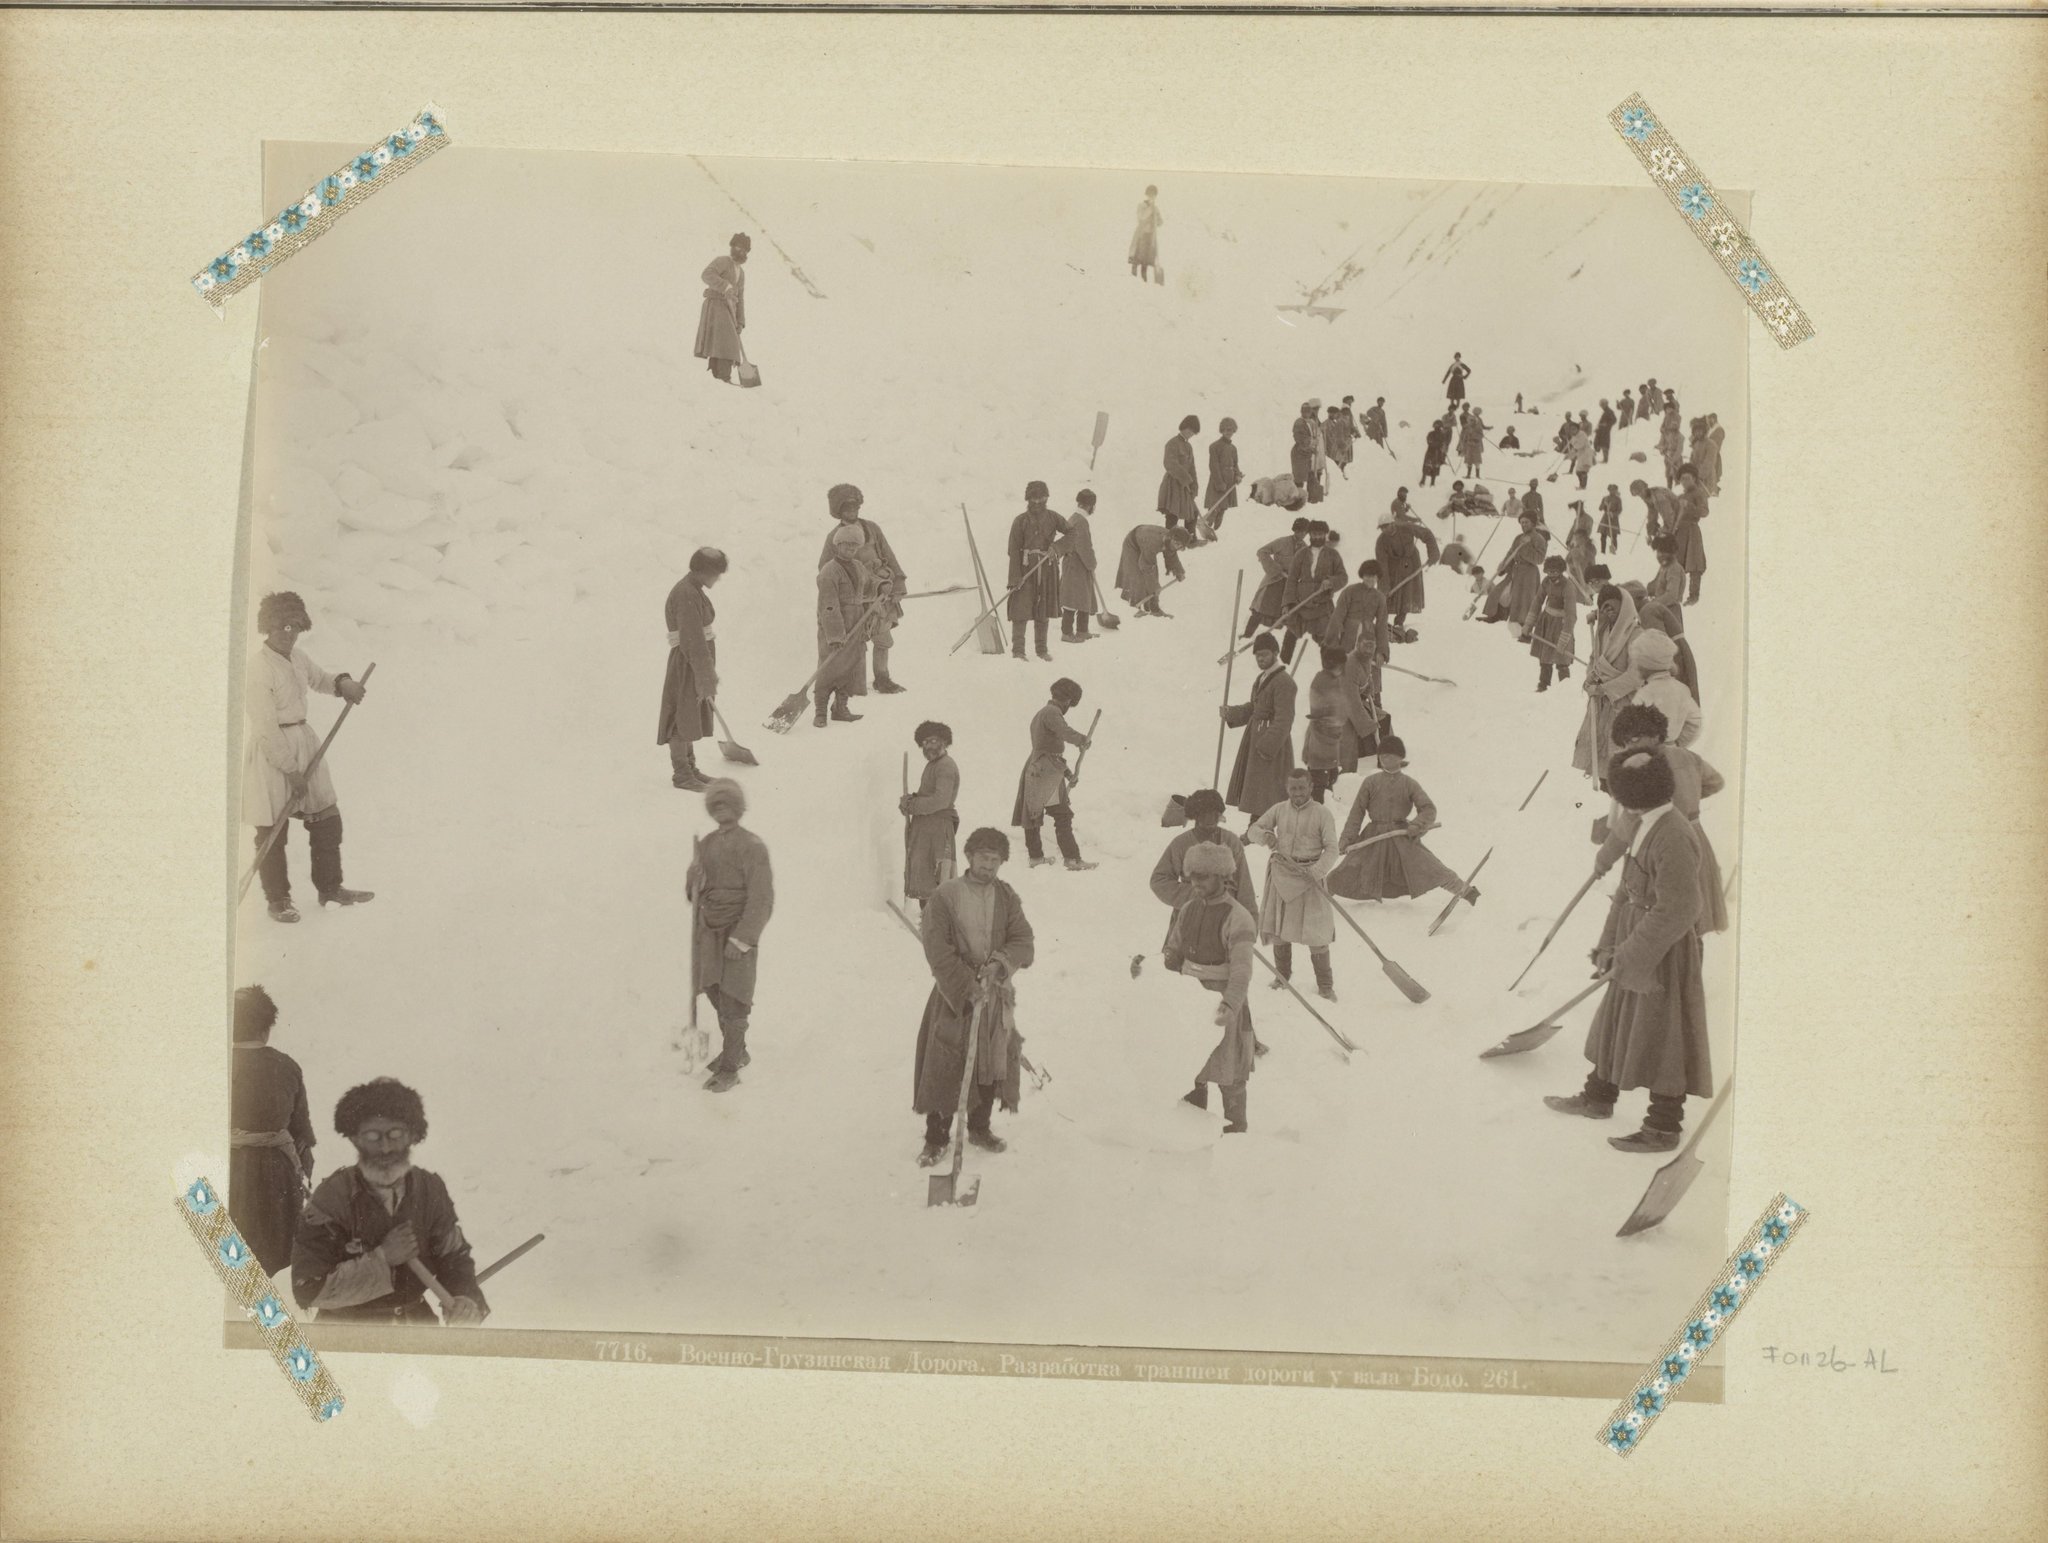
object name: photograph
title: Woenno-Groezinskaja doroga. Razrabotka traitsjoi dorogi oe wala Bodo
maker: dimitri ivanovitch ermakov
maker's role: fotograaf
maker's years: 1845-1916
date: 1890-1900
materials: photographic support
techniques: albumen print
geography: georgia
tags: adult man, snow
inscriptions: number: ‘7716’, number: ‘261’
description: Onderdeel van Fotoalbum met opnames van bezienswaardigheden in Georgië, Sint-Petersburg en Moskou.